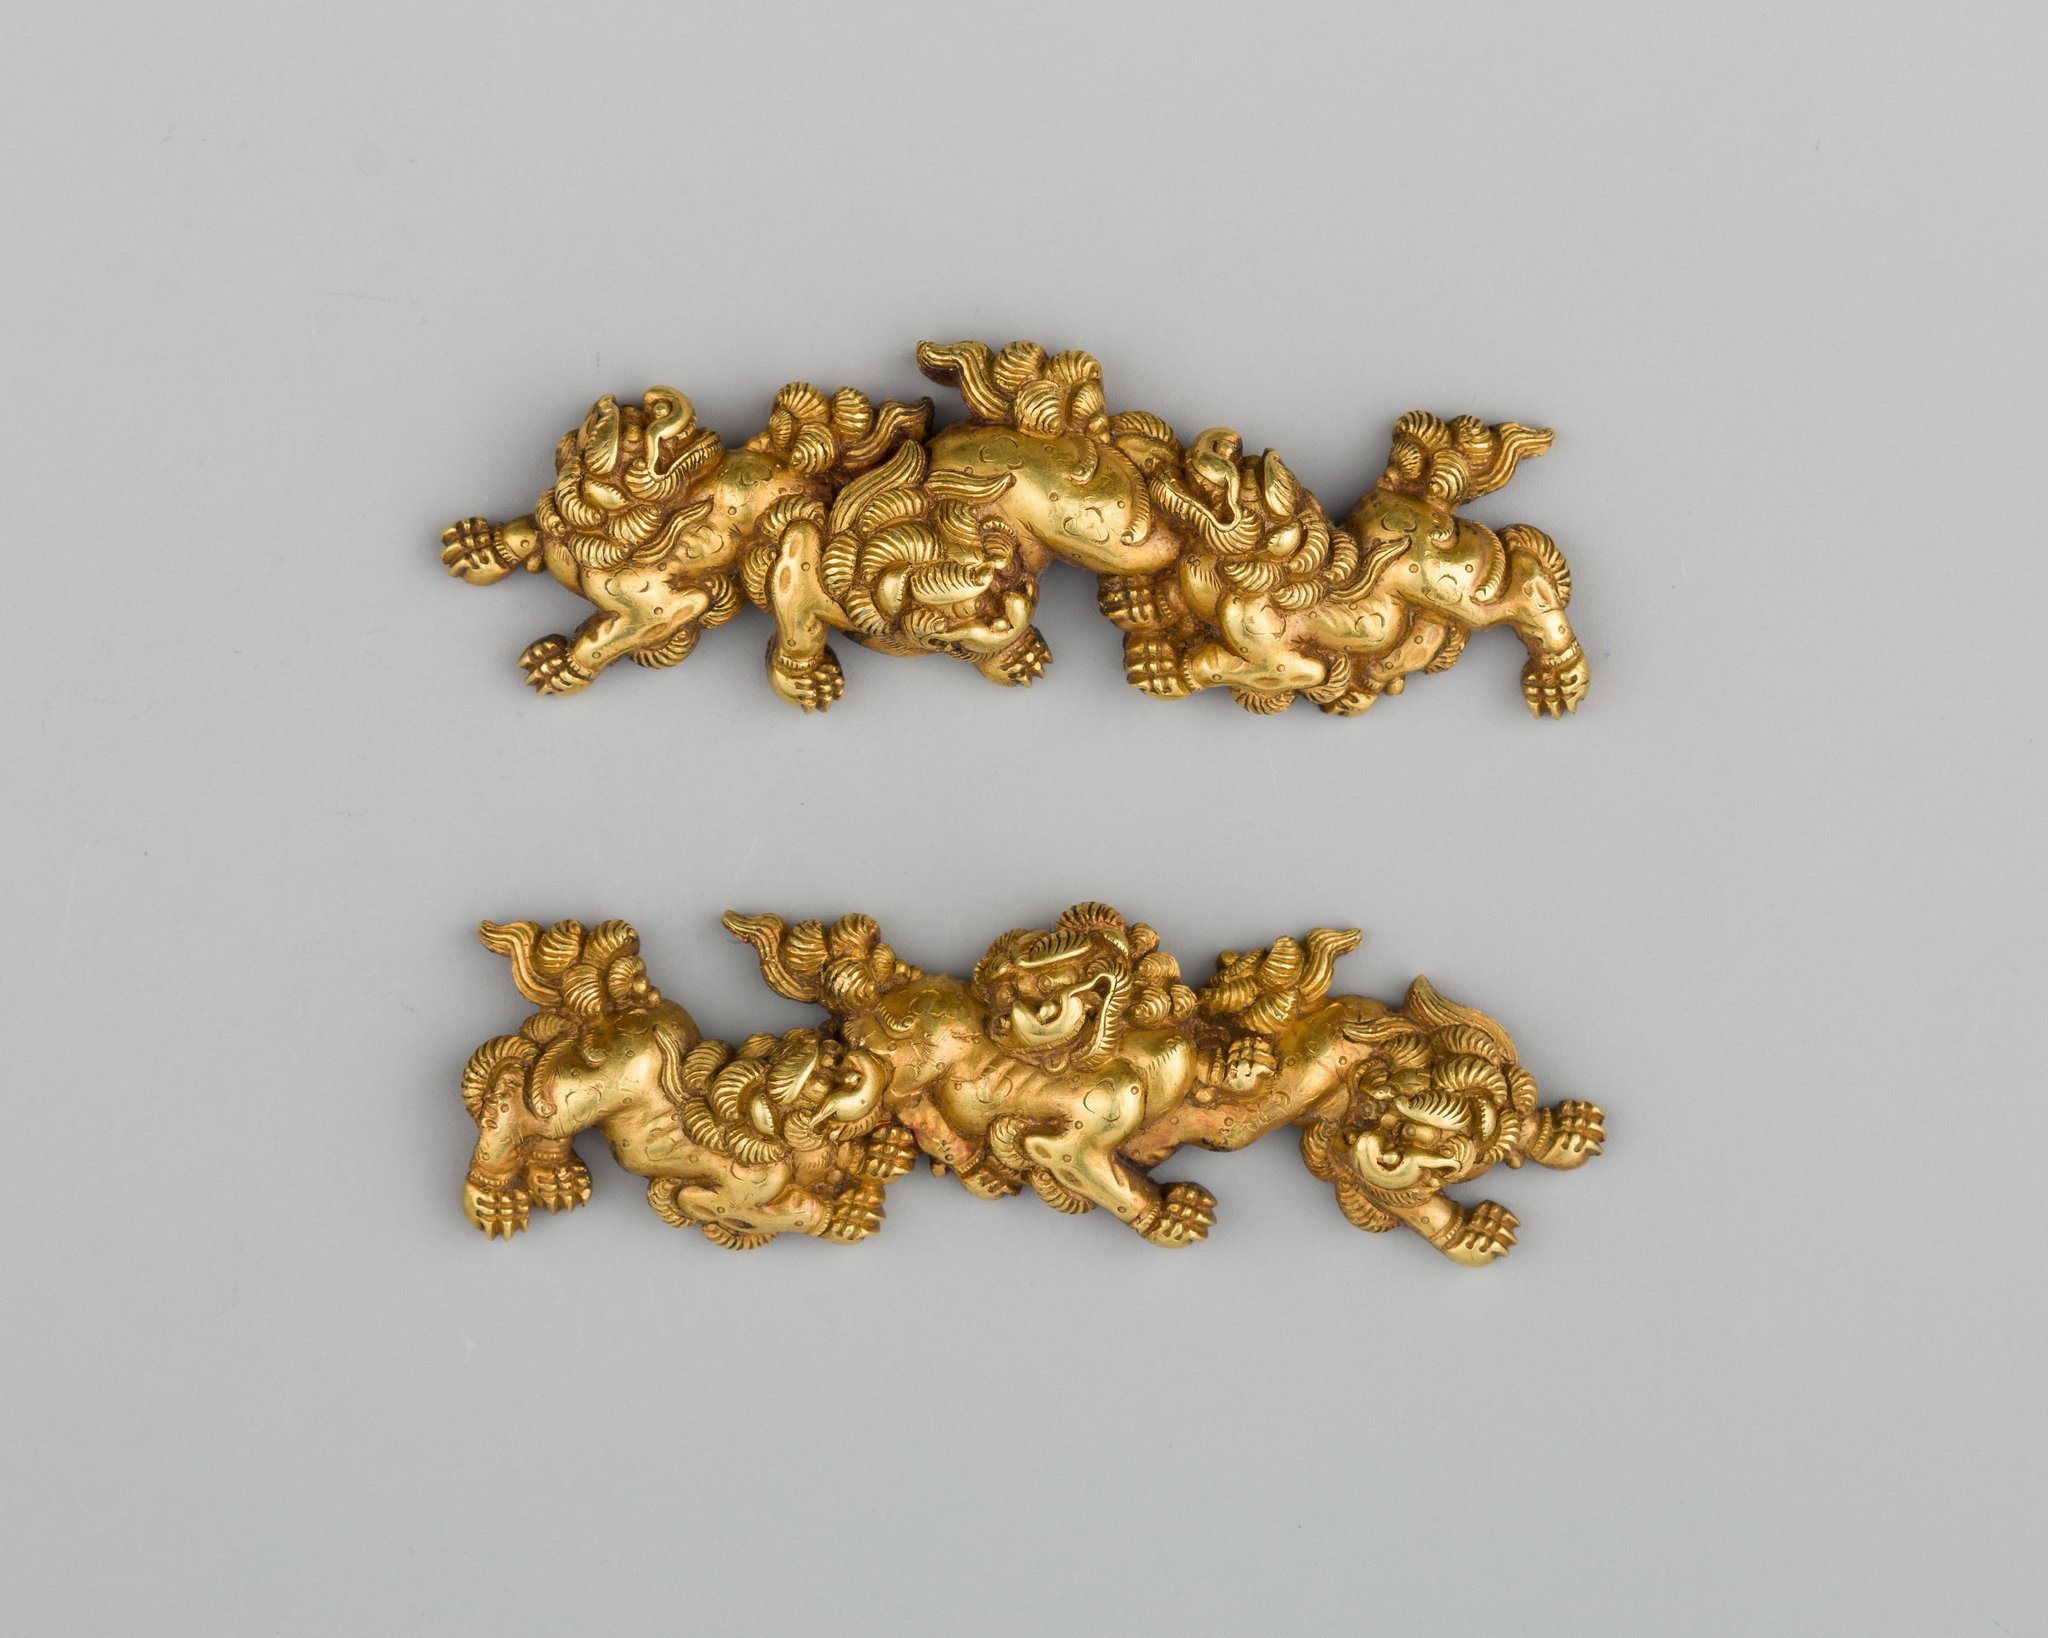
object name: pair of sword grip ornament menuki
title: Pair of Sword-Grip Ornaments (Menuki)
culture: japanese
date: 1701-1800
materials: gold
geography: japan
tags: flowers